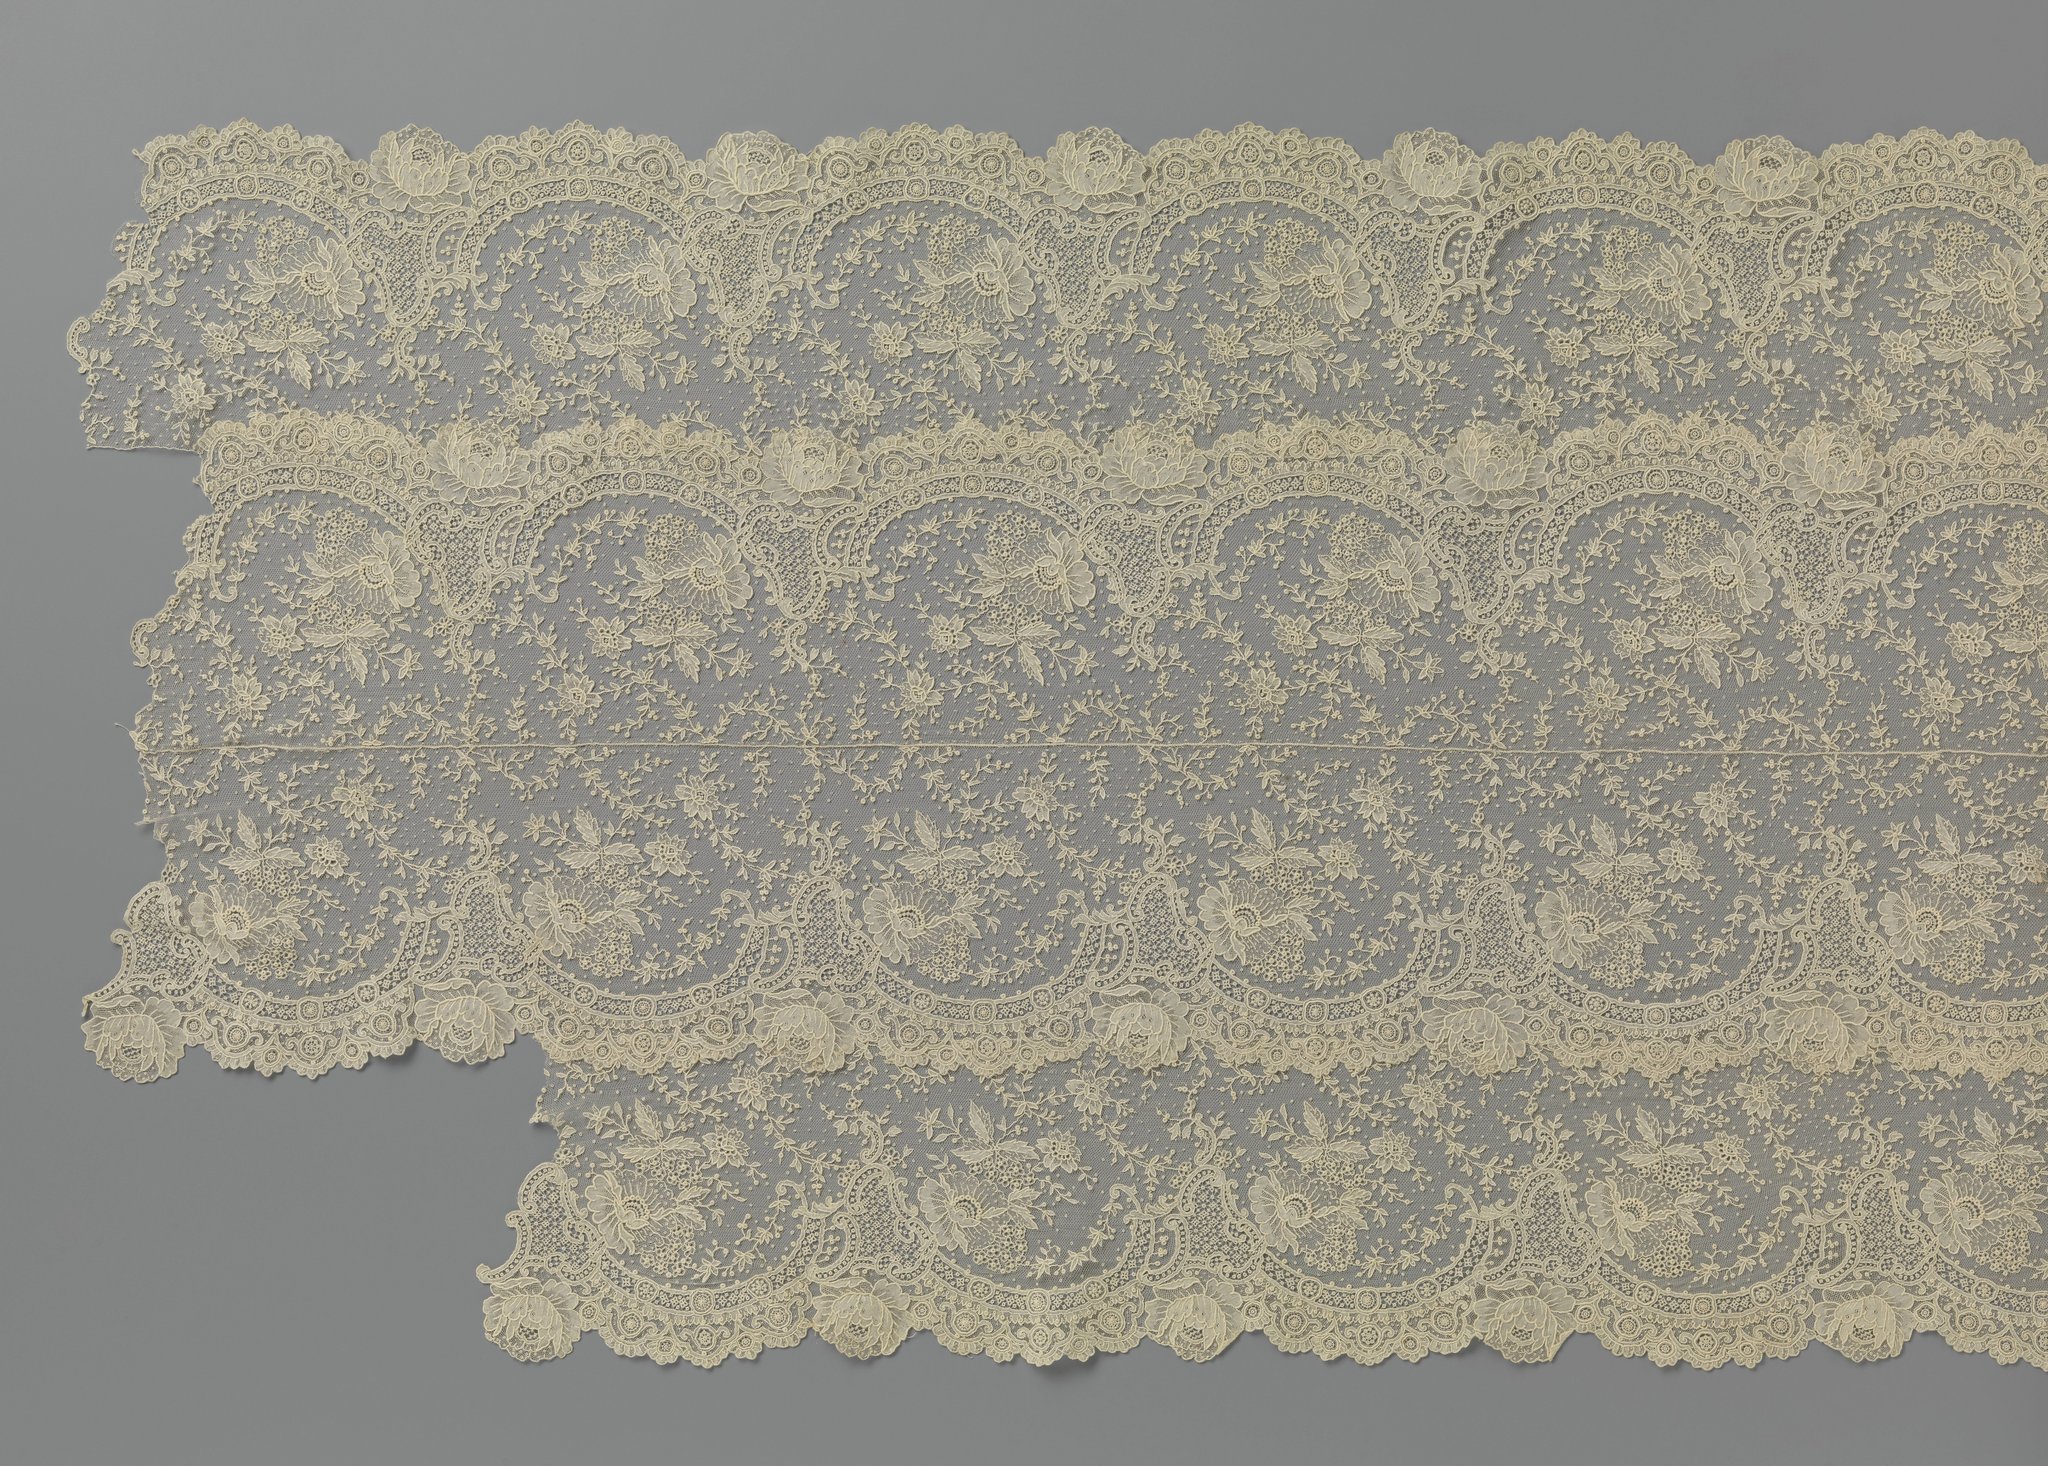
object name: overdress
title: Achterpand van een overjapon van naaldkant met pioenrozen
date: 1870-1890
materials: linen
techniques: needle lace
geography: brussels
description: Los achterpand samengesteld uit vier smallere stroken, de schulpen twee aan twee buitenwaarts gekeerd. Diepe schulpen van bandwerk met rasterpatroon en afhangende campanes vertonen als sluitstuk een pioenroos hangende onder een asymmetrische rocaille, eveneens gevuld met rasterpatroon. In de schulpen staan naar rechts opgaande stengels met anemonen en seringen. Het fond is bezaaid met moesjes. Point de gaze de Bruxelles.